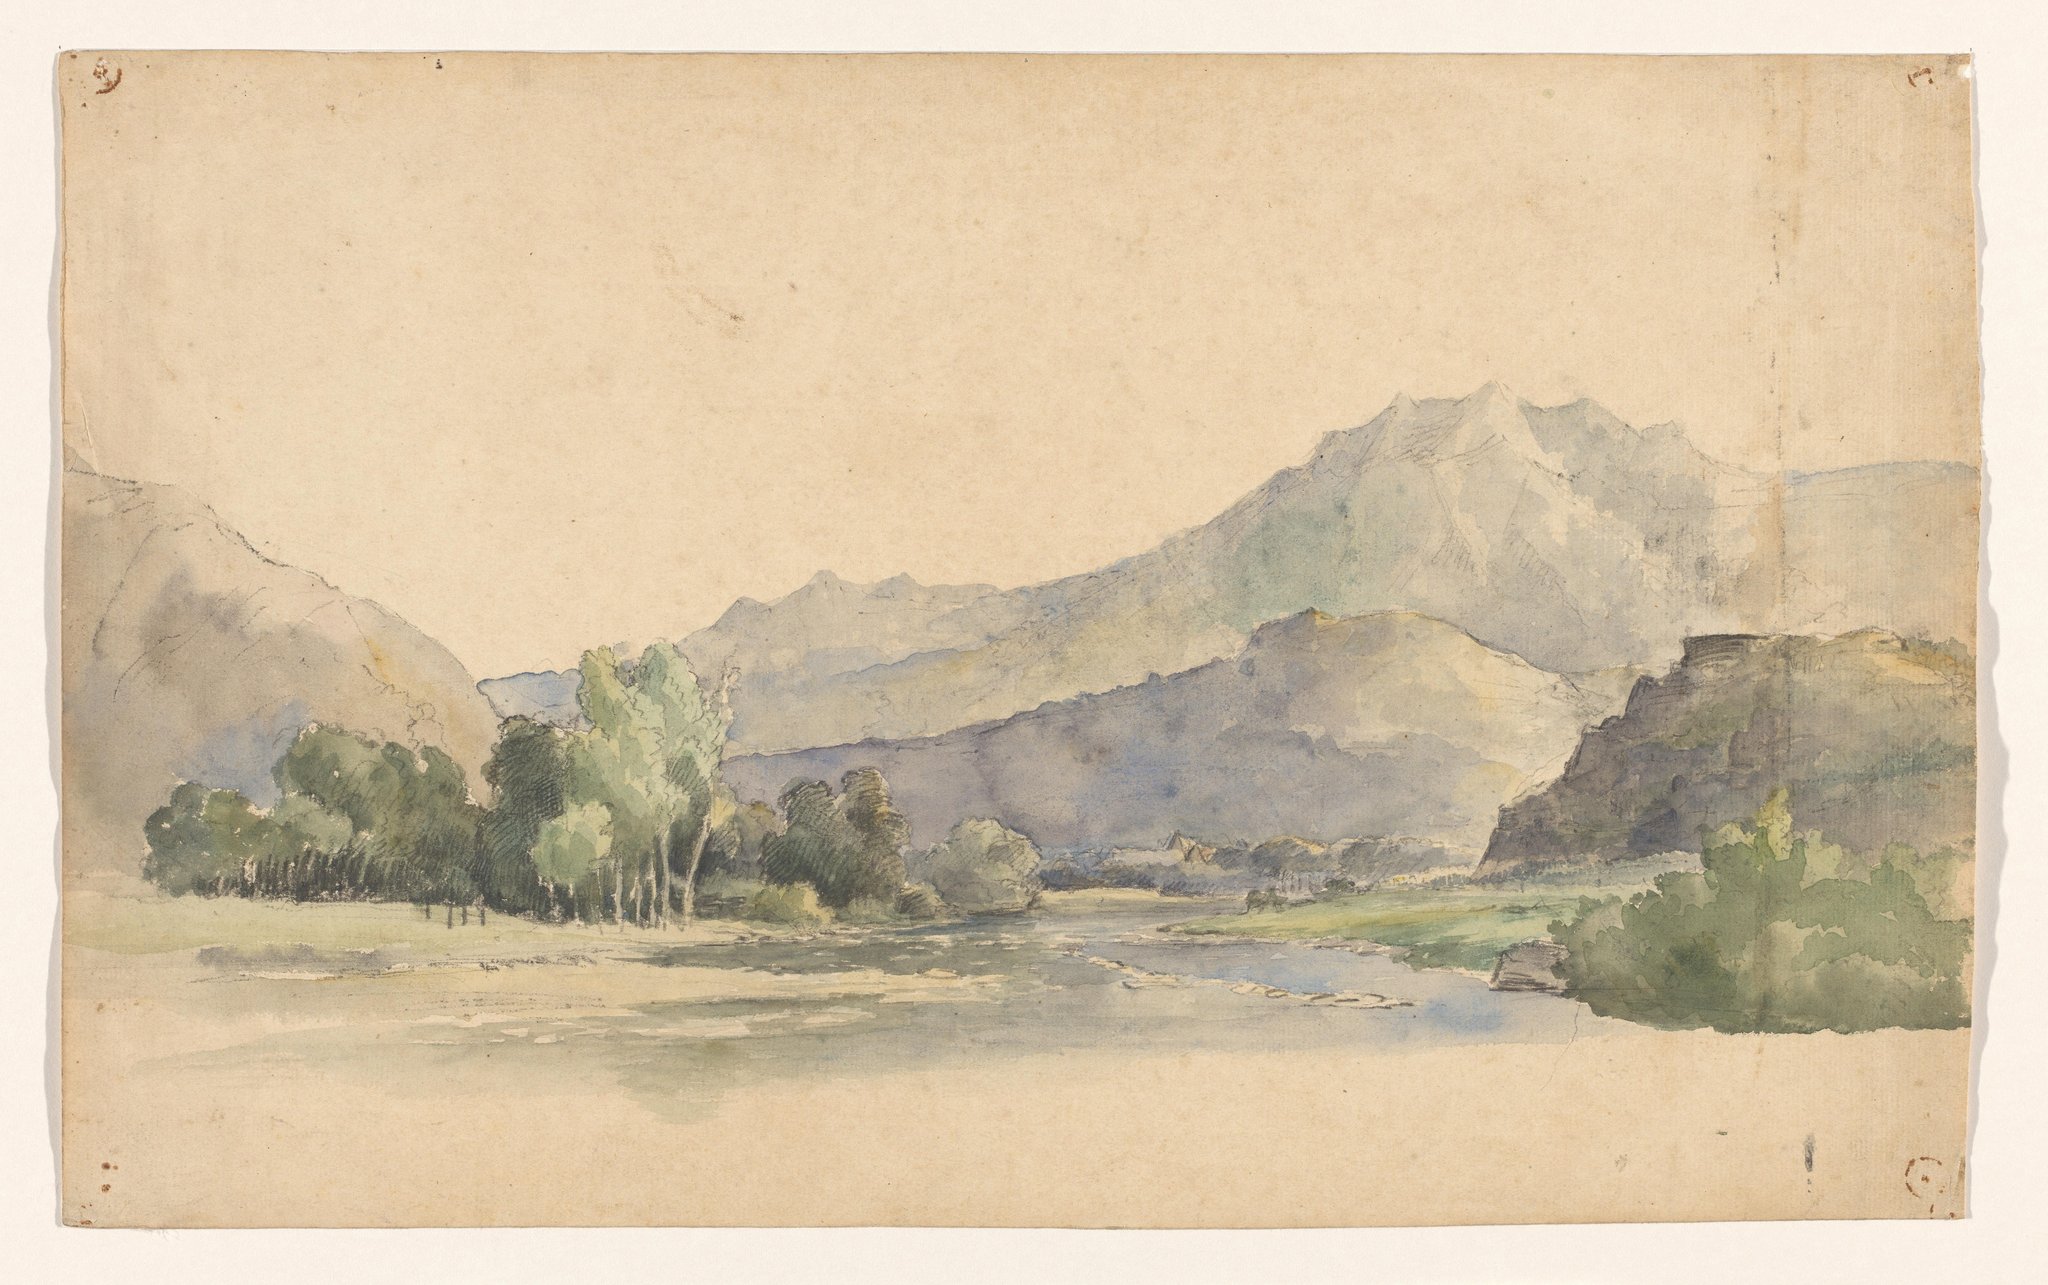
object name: drawing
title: Landschap met bergen en bomen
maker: jan bedijs tom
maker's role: draughtsman, painter, print maker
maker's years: 1813-1894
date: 1823-1894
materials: chalk, paper, watercolor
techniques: brush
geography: the hague